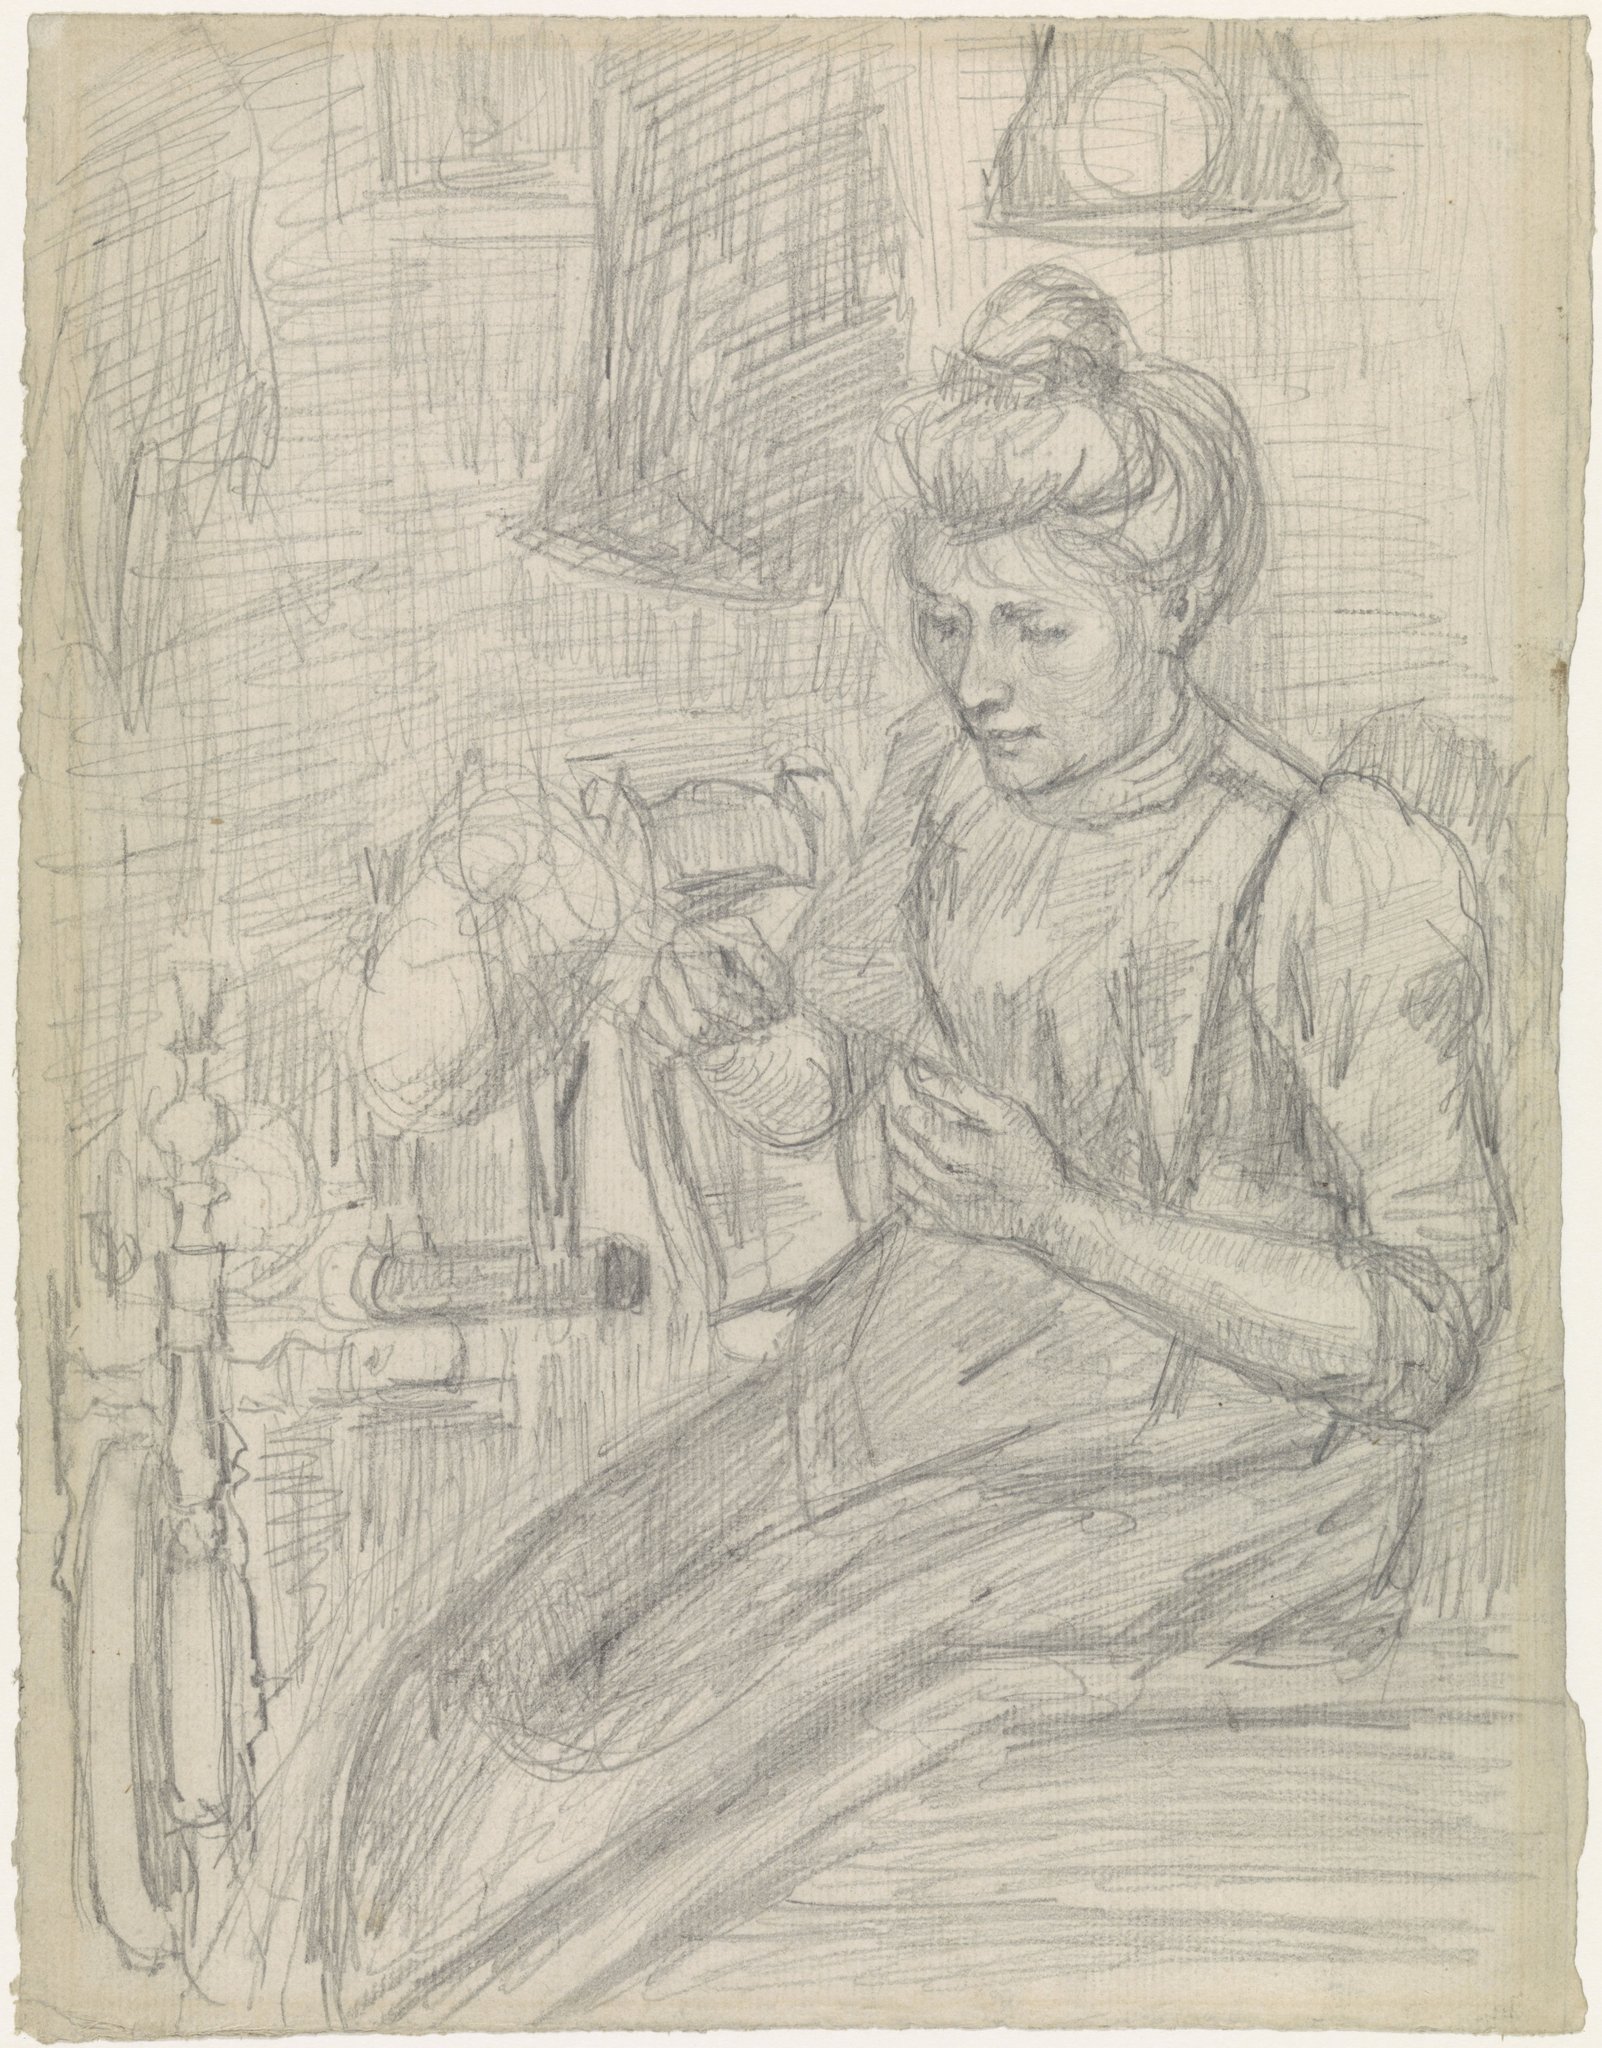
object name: drawing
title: Spinnende vrouw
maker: jozef israëls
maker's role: draughtsman, painter, print maker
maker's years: 1824-1911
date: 1834-1911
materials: paper, pencil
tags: spinning (manufacture of yarn)